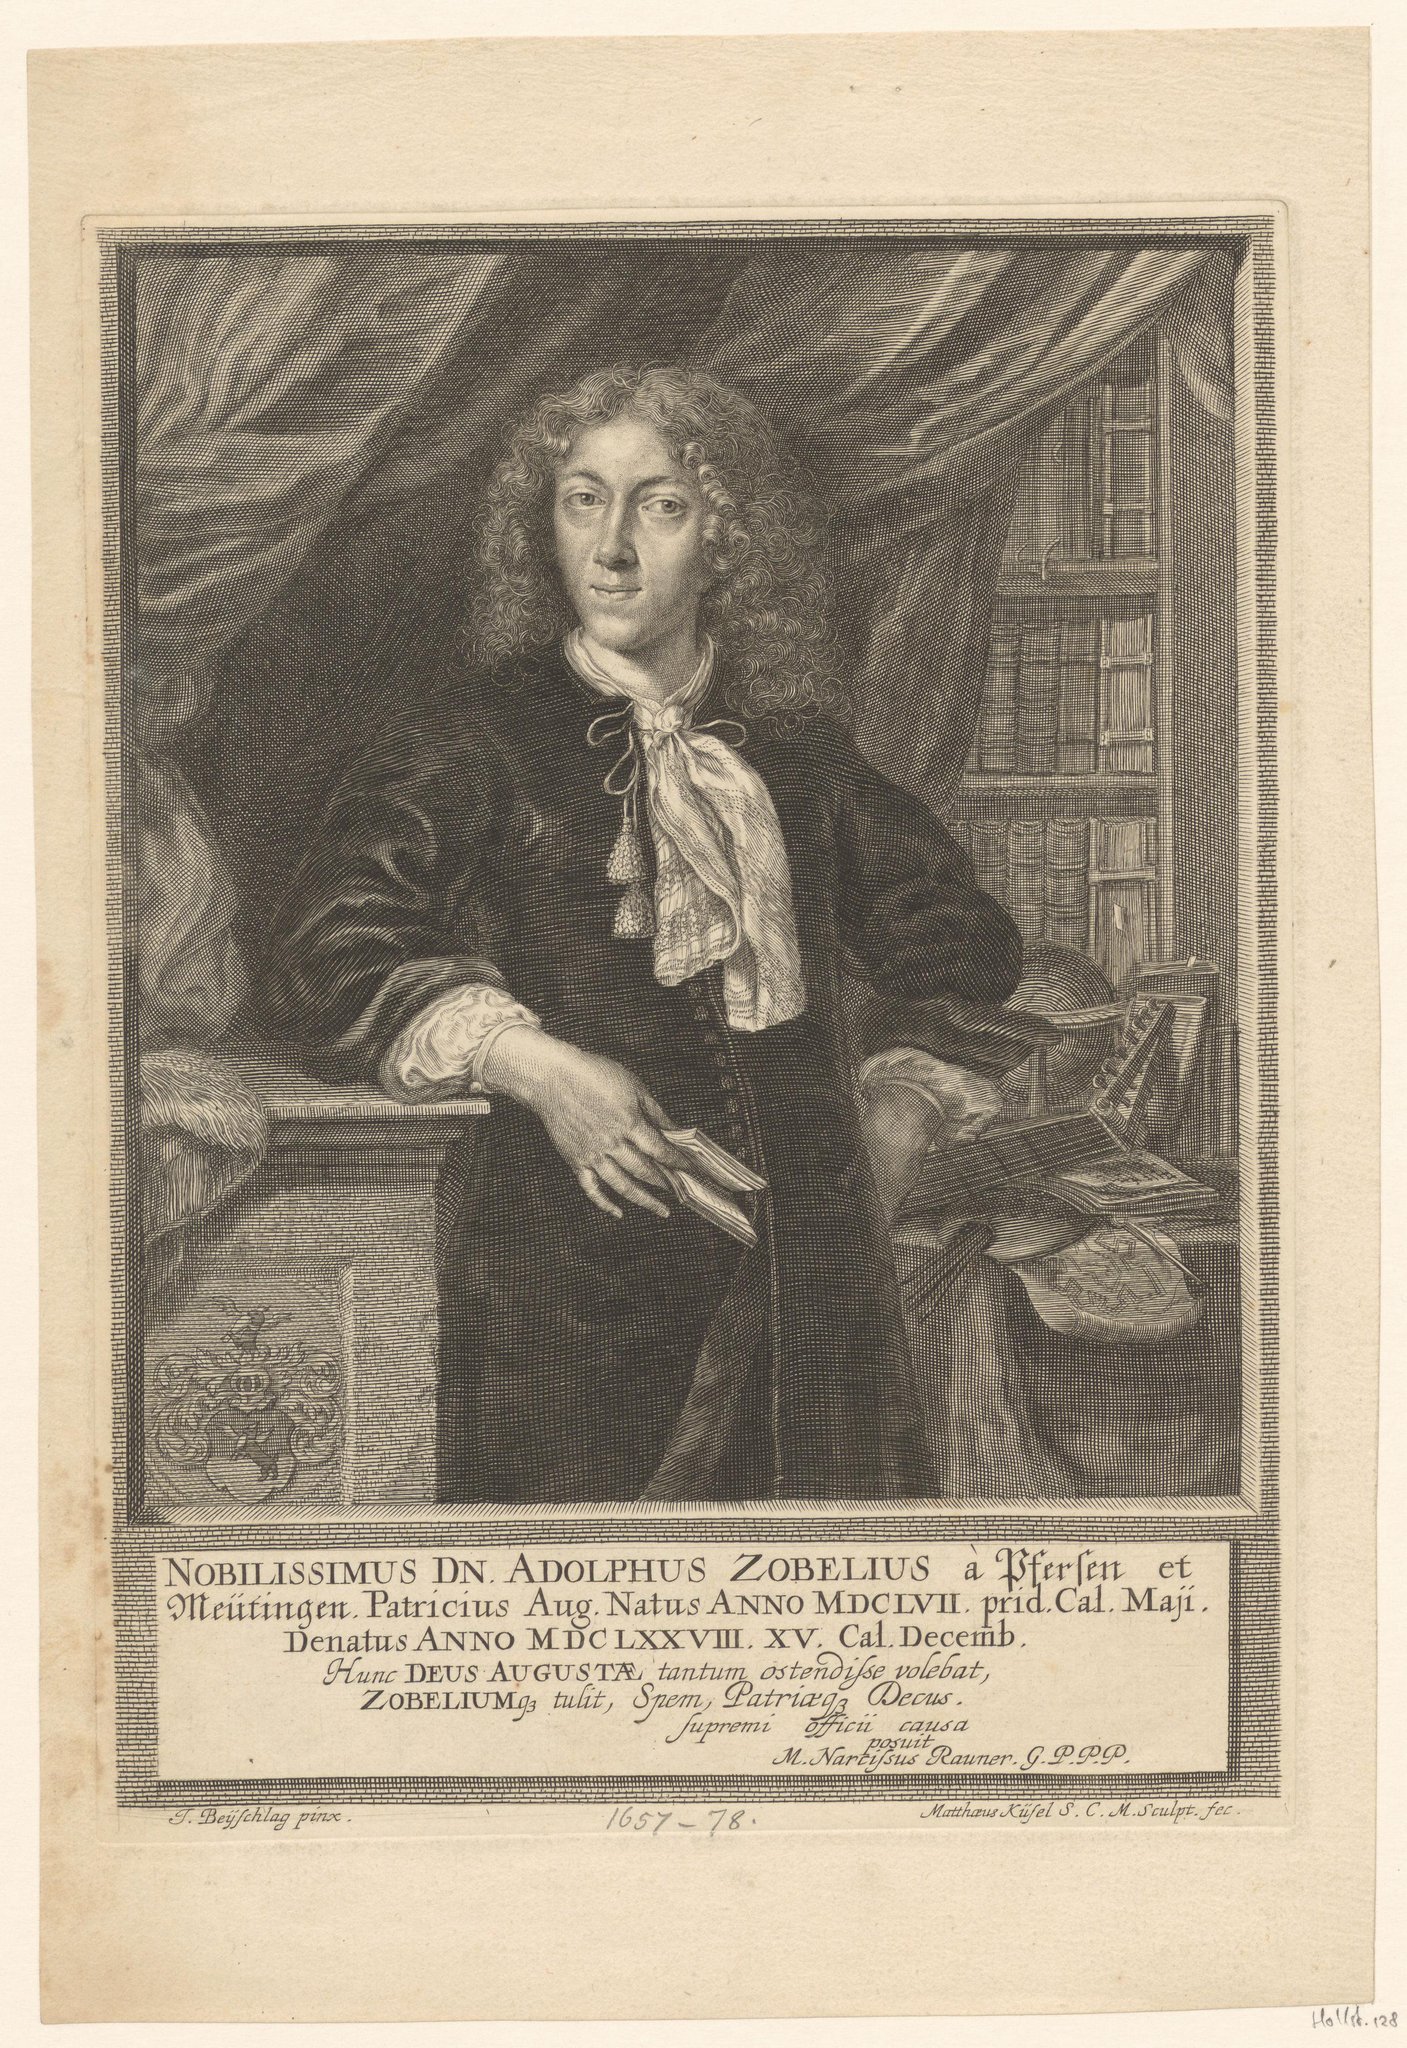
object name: print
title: Portret van Adolph Zobel von Pfersen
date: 1678-1681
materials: paper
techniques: engraving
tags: augsburg, painting, drawing and the graphic arts (+ materials ~ arts), historical persons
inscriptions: collector's mark: Lugt 2228